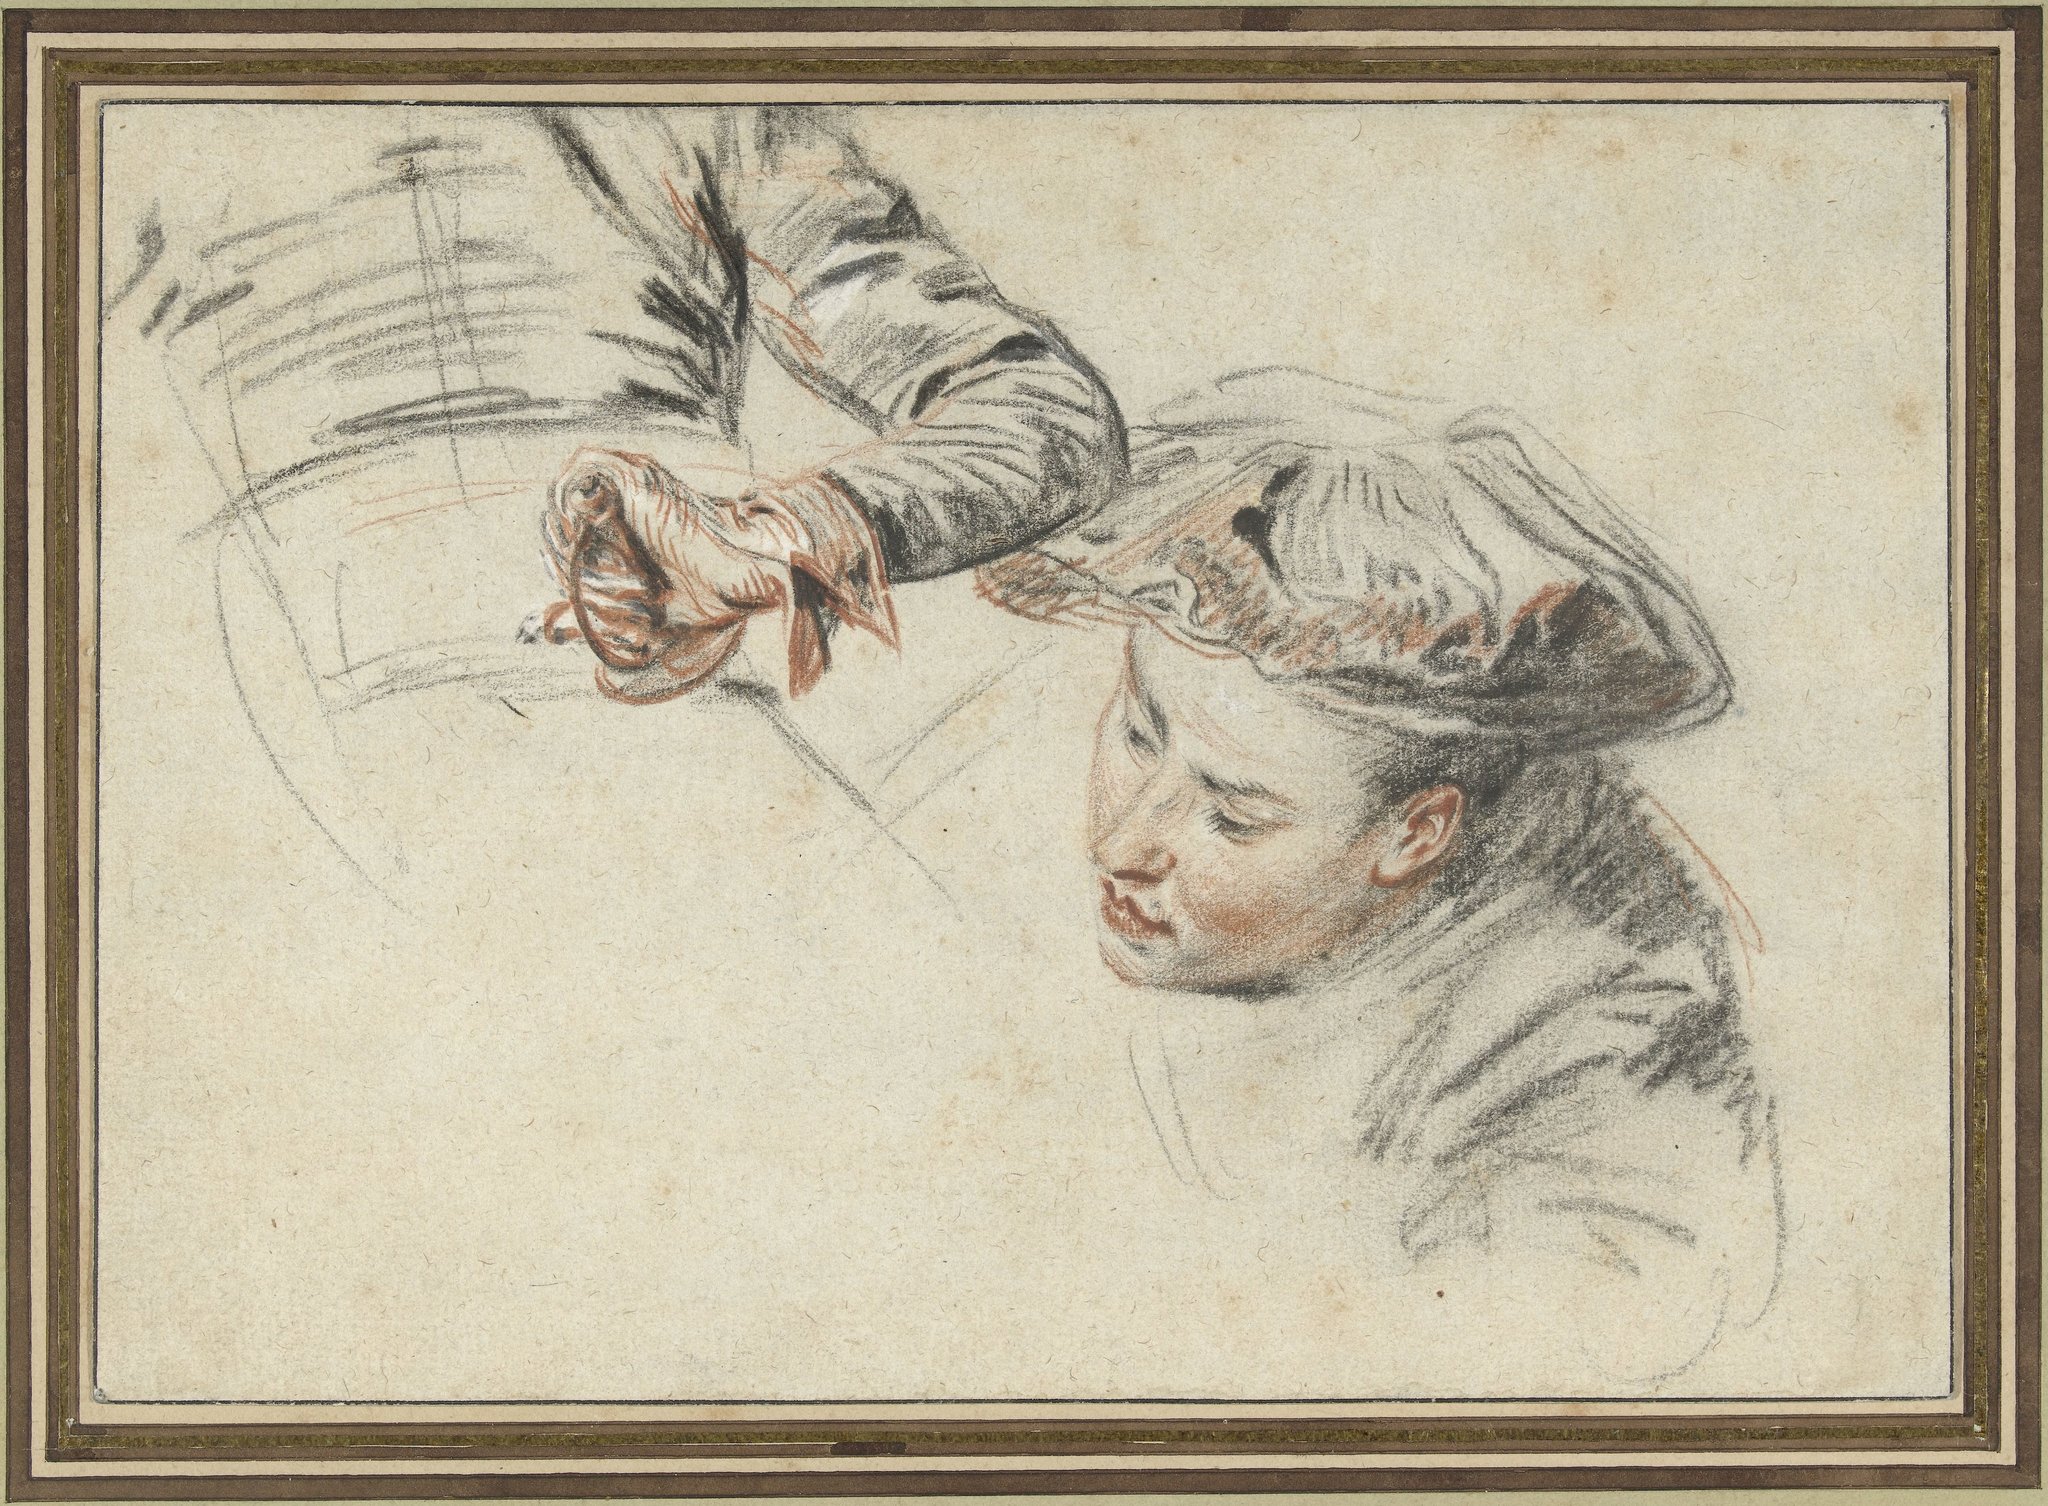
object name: drawing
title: Manskop met baret en een hand aan een gevest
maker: jean antoine watteau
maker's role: draughtsman, print maker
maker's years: 1684-1721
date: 1717-1719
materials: chalk, paper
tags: head-gear: beret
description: De studie van de hand aan een gevest is toegepast in een schilderij: Arlequin, Pierrot et Scapin (verblijfplaats onbekend), waarnaar ook een prent is gemaakt in 1719 door Louis Surugue.